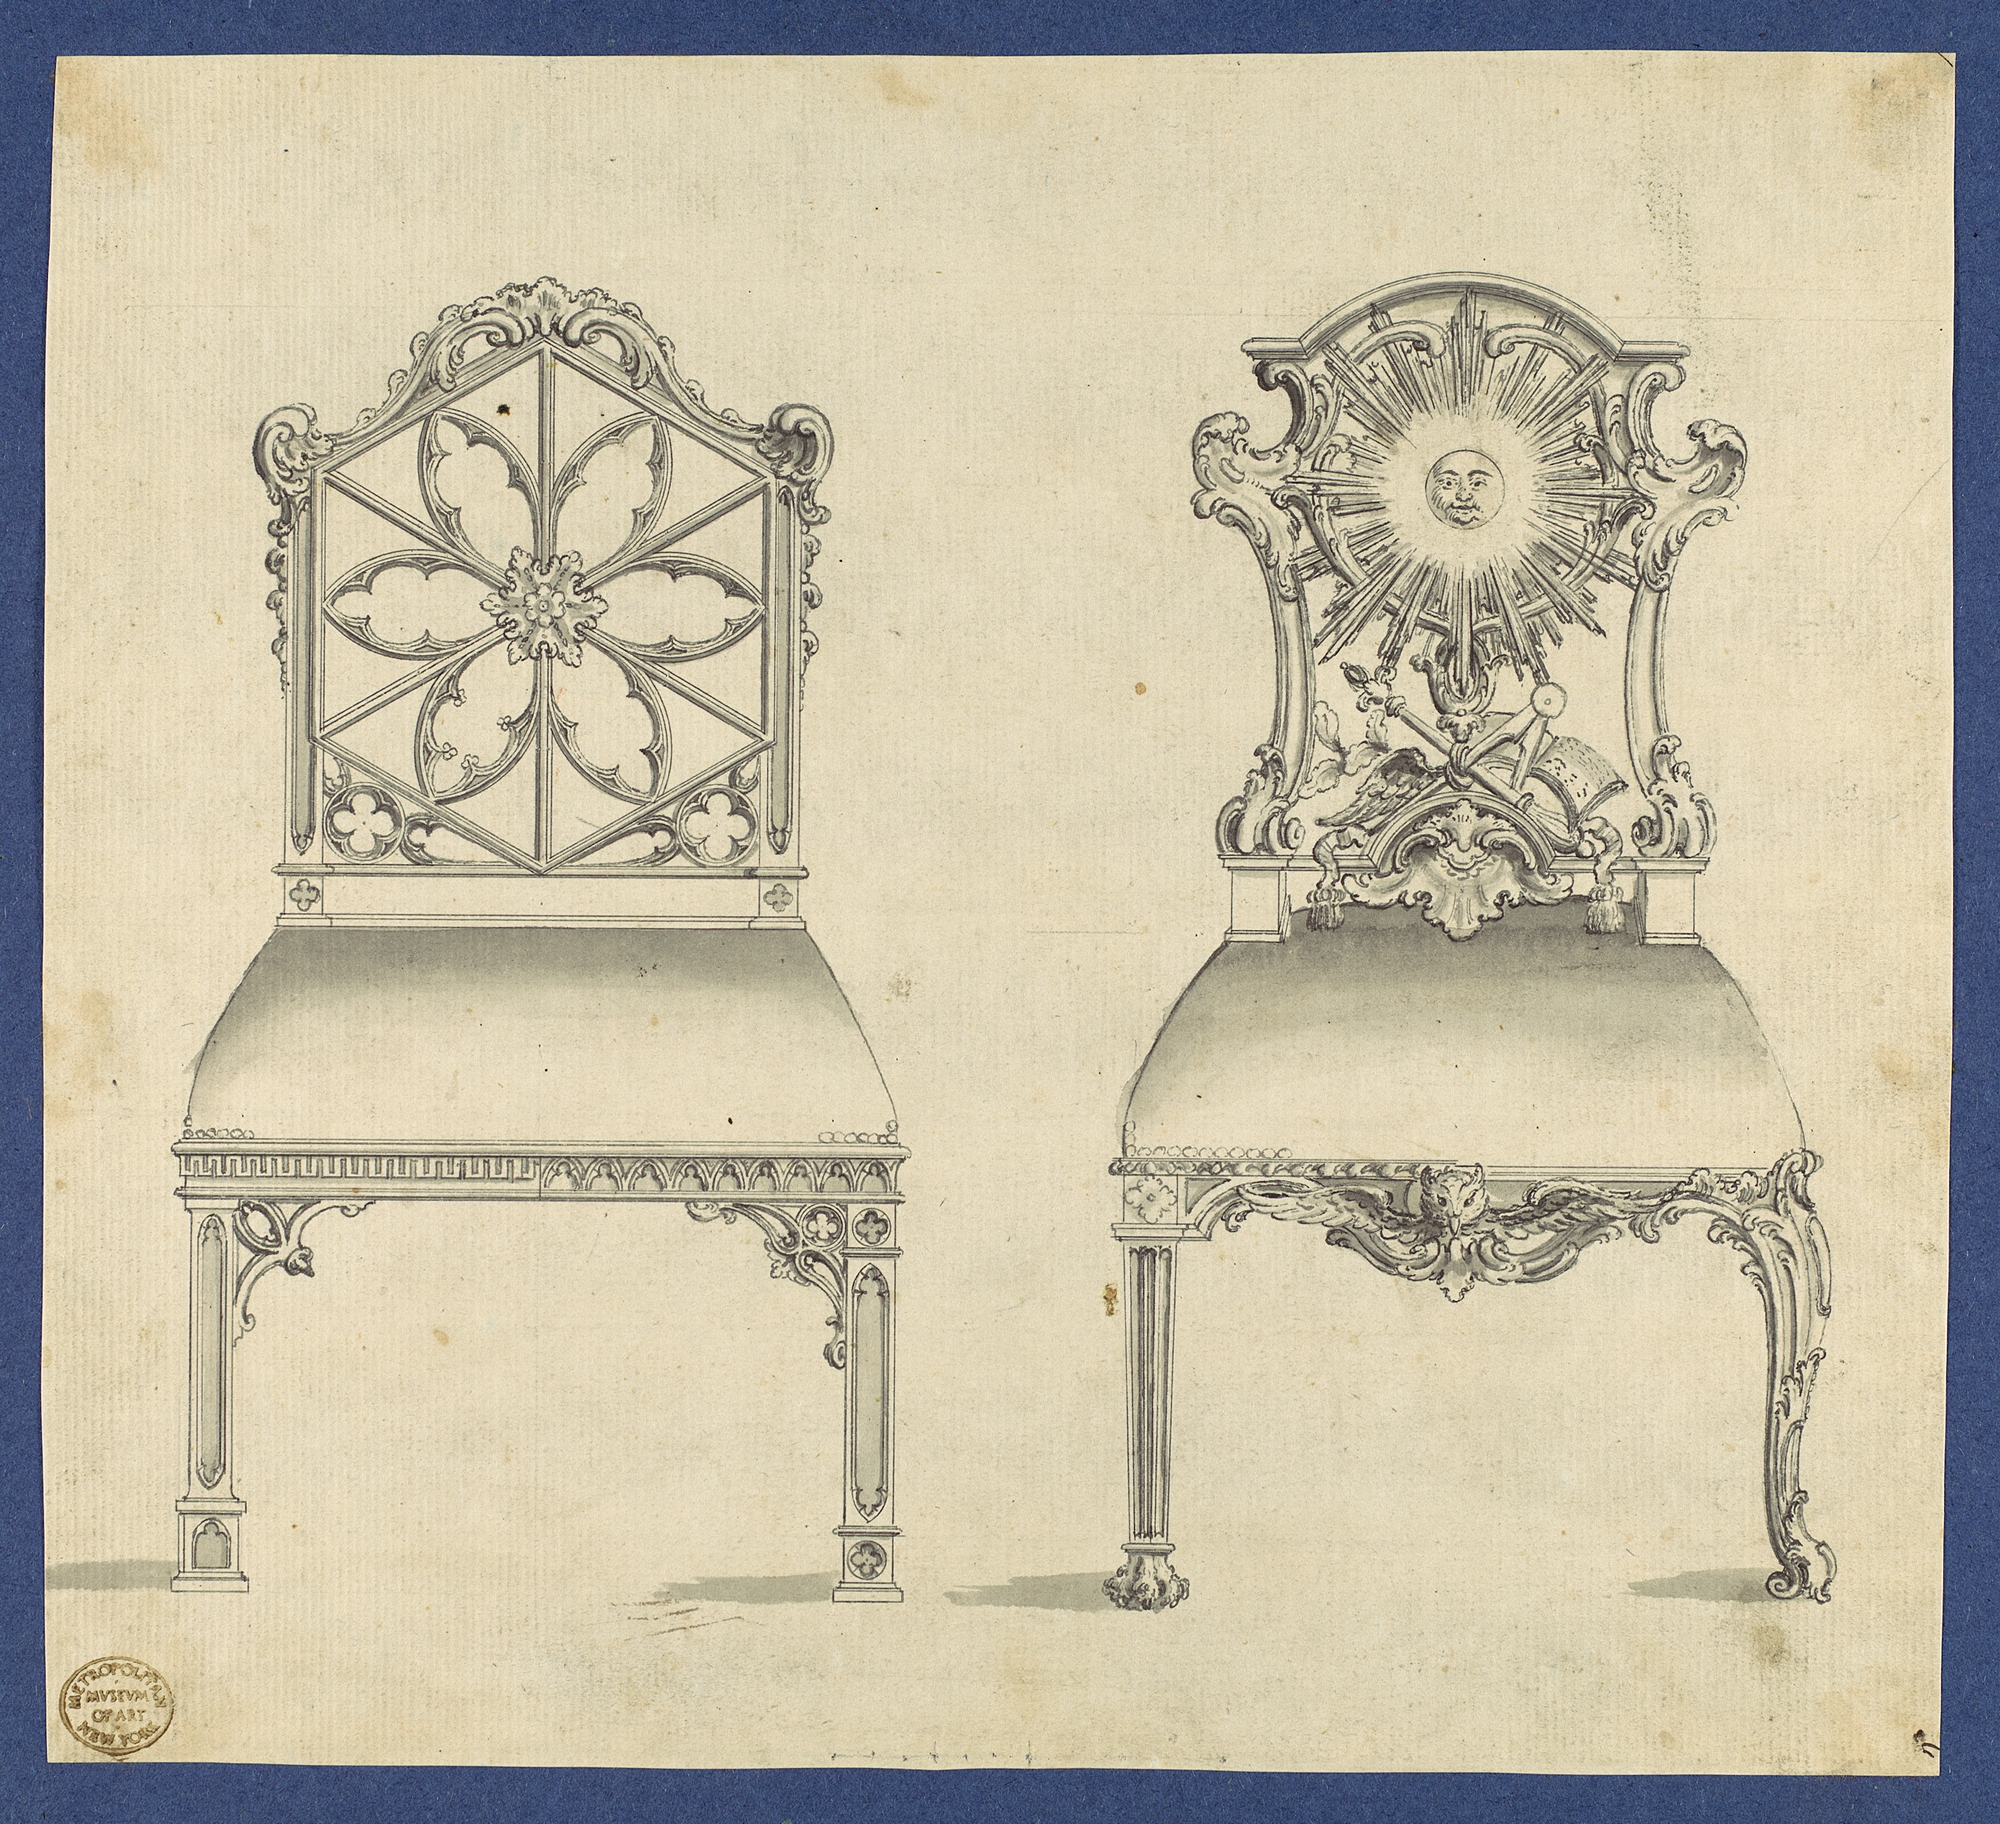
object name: drawing ornament architecture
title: Gothick [Gothic] Chairs, in Chippendale Drawings, Vol. I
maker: thomas chippendale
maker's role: artist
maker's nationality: british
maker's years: 1718-1779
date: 1761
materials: ink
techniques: wash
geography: london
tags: chairs